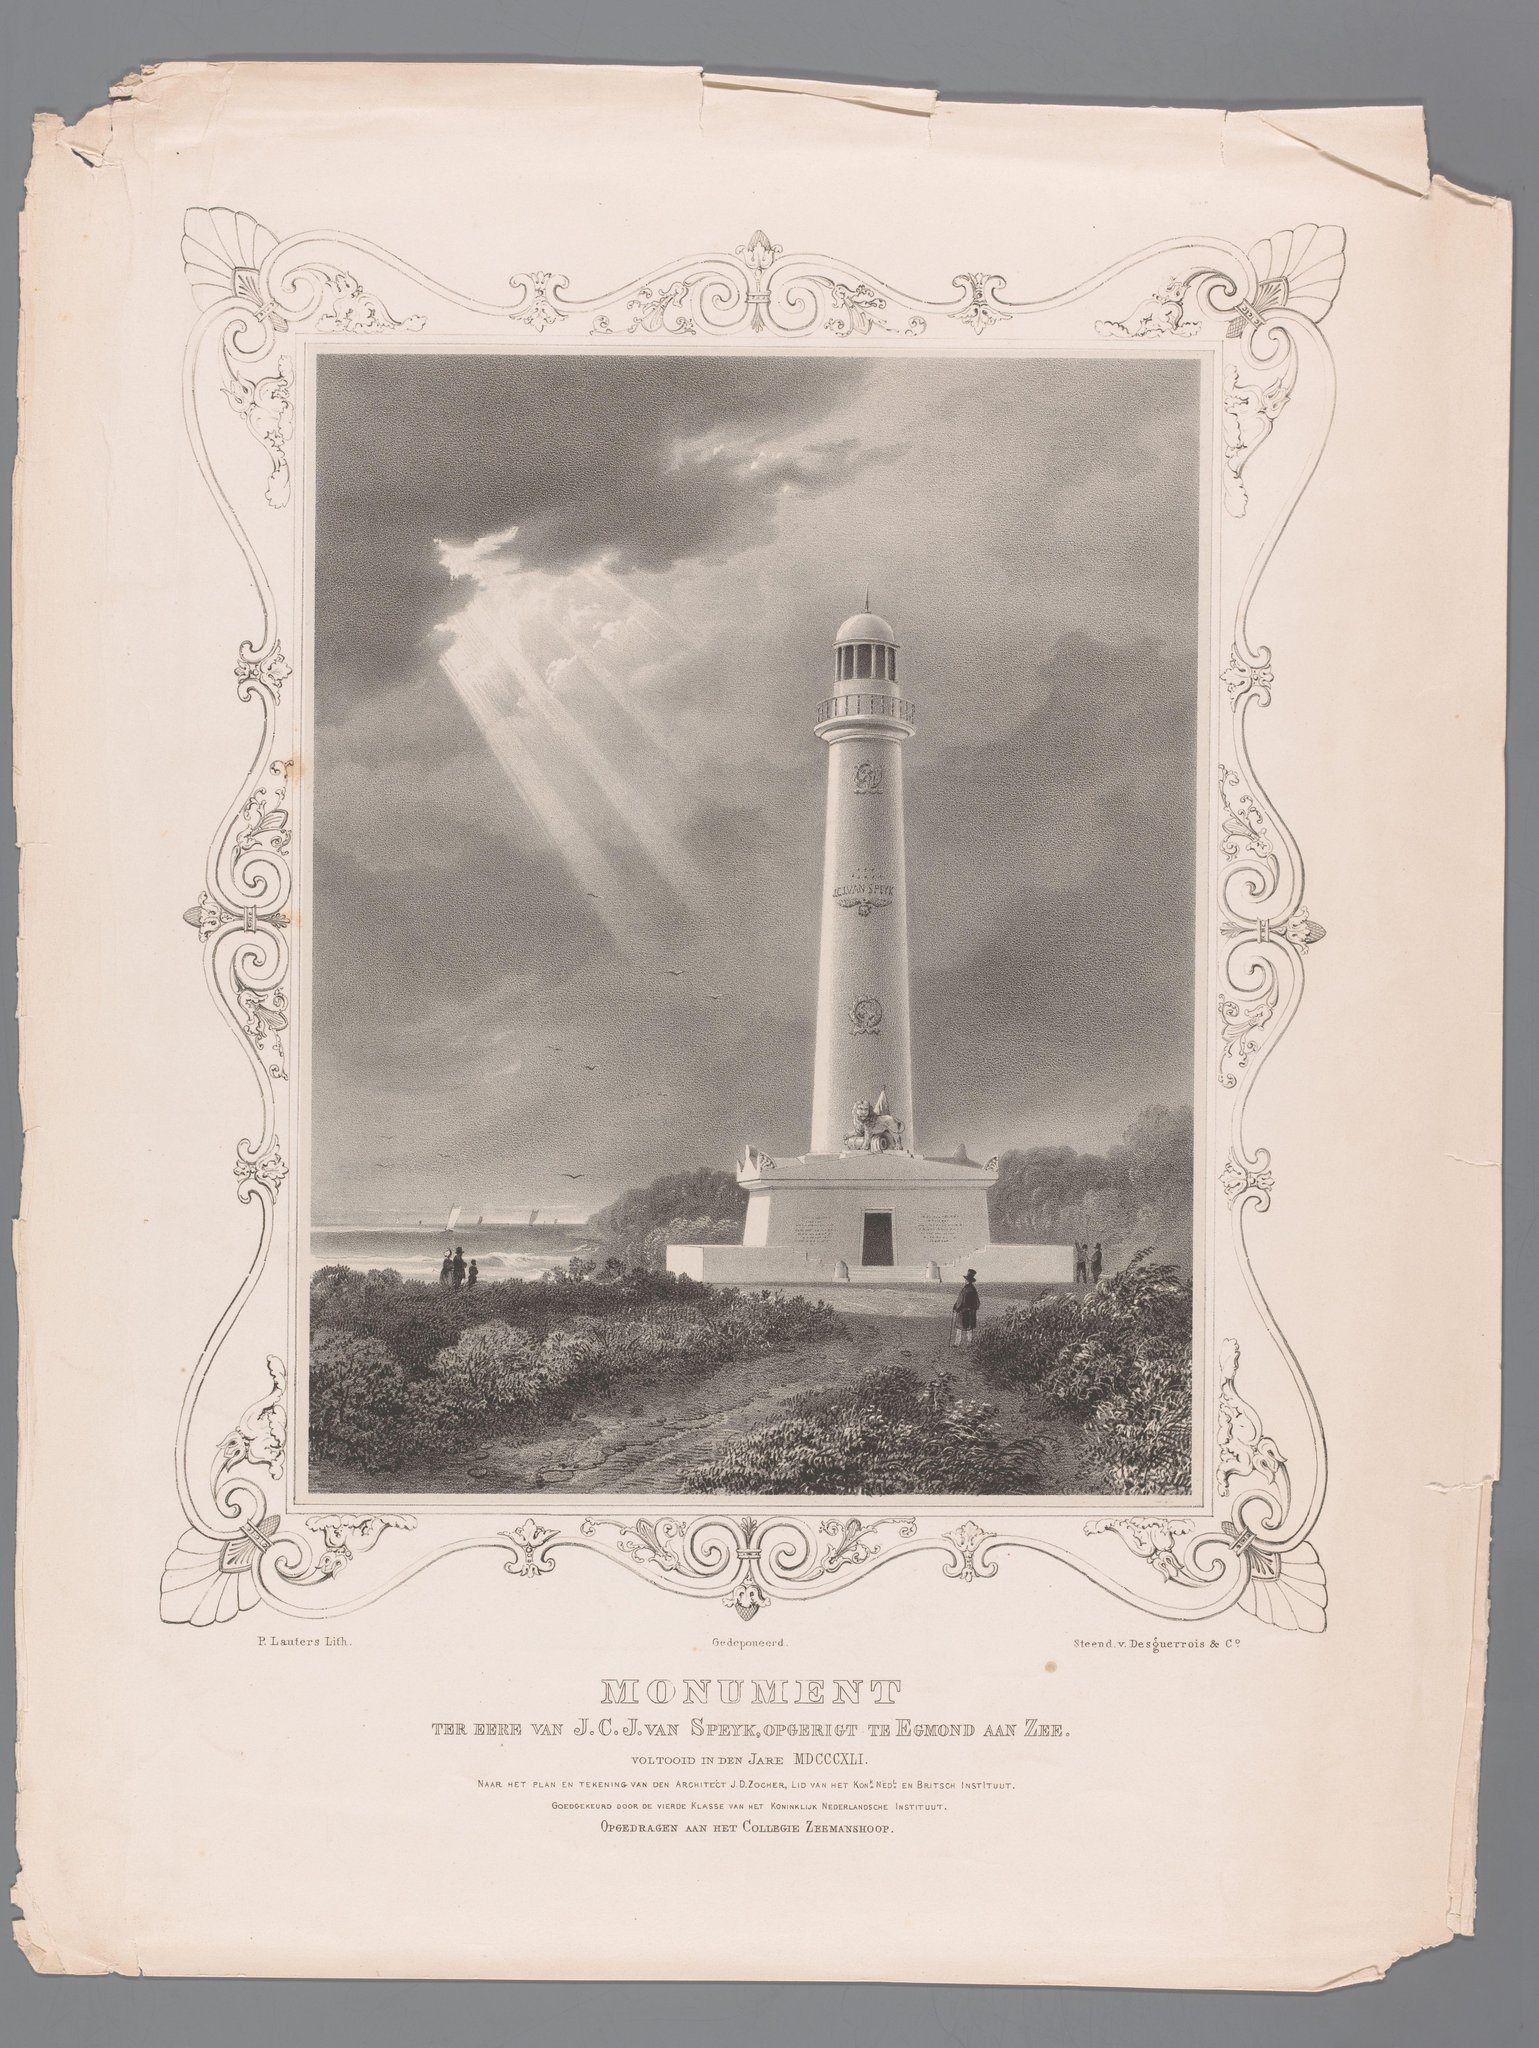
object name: print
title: Vuurtoren met monument ter ere van Jan Carel Josephus van Speyk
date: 1841-1875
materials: paper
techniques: lithograph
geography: amsterdam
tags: amsterdam, antwerp, jan van speyk, lighthouse, lightship, monument, statue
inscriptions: : ‘Gedeponeerd’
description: Gezicht op de vuurtoren J.C.J. van Speyk te Egmond aan Zee. De bestaande oorspronkelijke vuurtoren met de naam Noordertoren werd in 1834 volgens het ontwerp van J.D. Zocher omgebouwd tot een monument, de monumentale ingang met leeuw aan de voet werd voltooid in 1841.